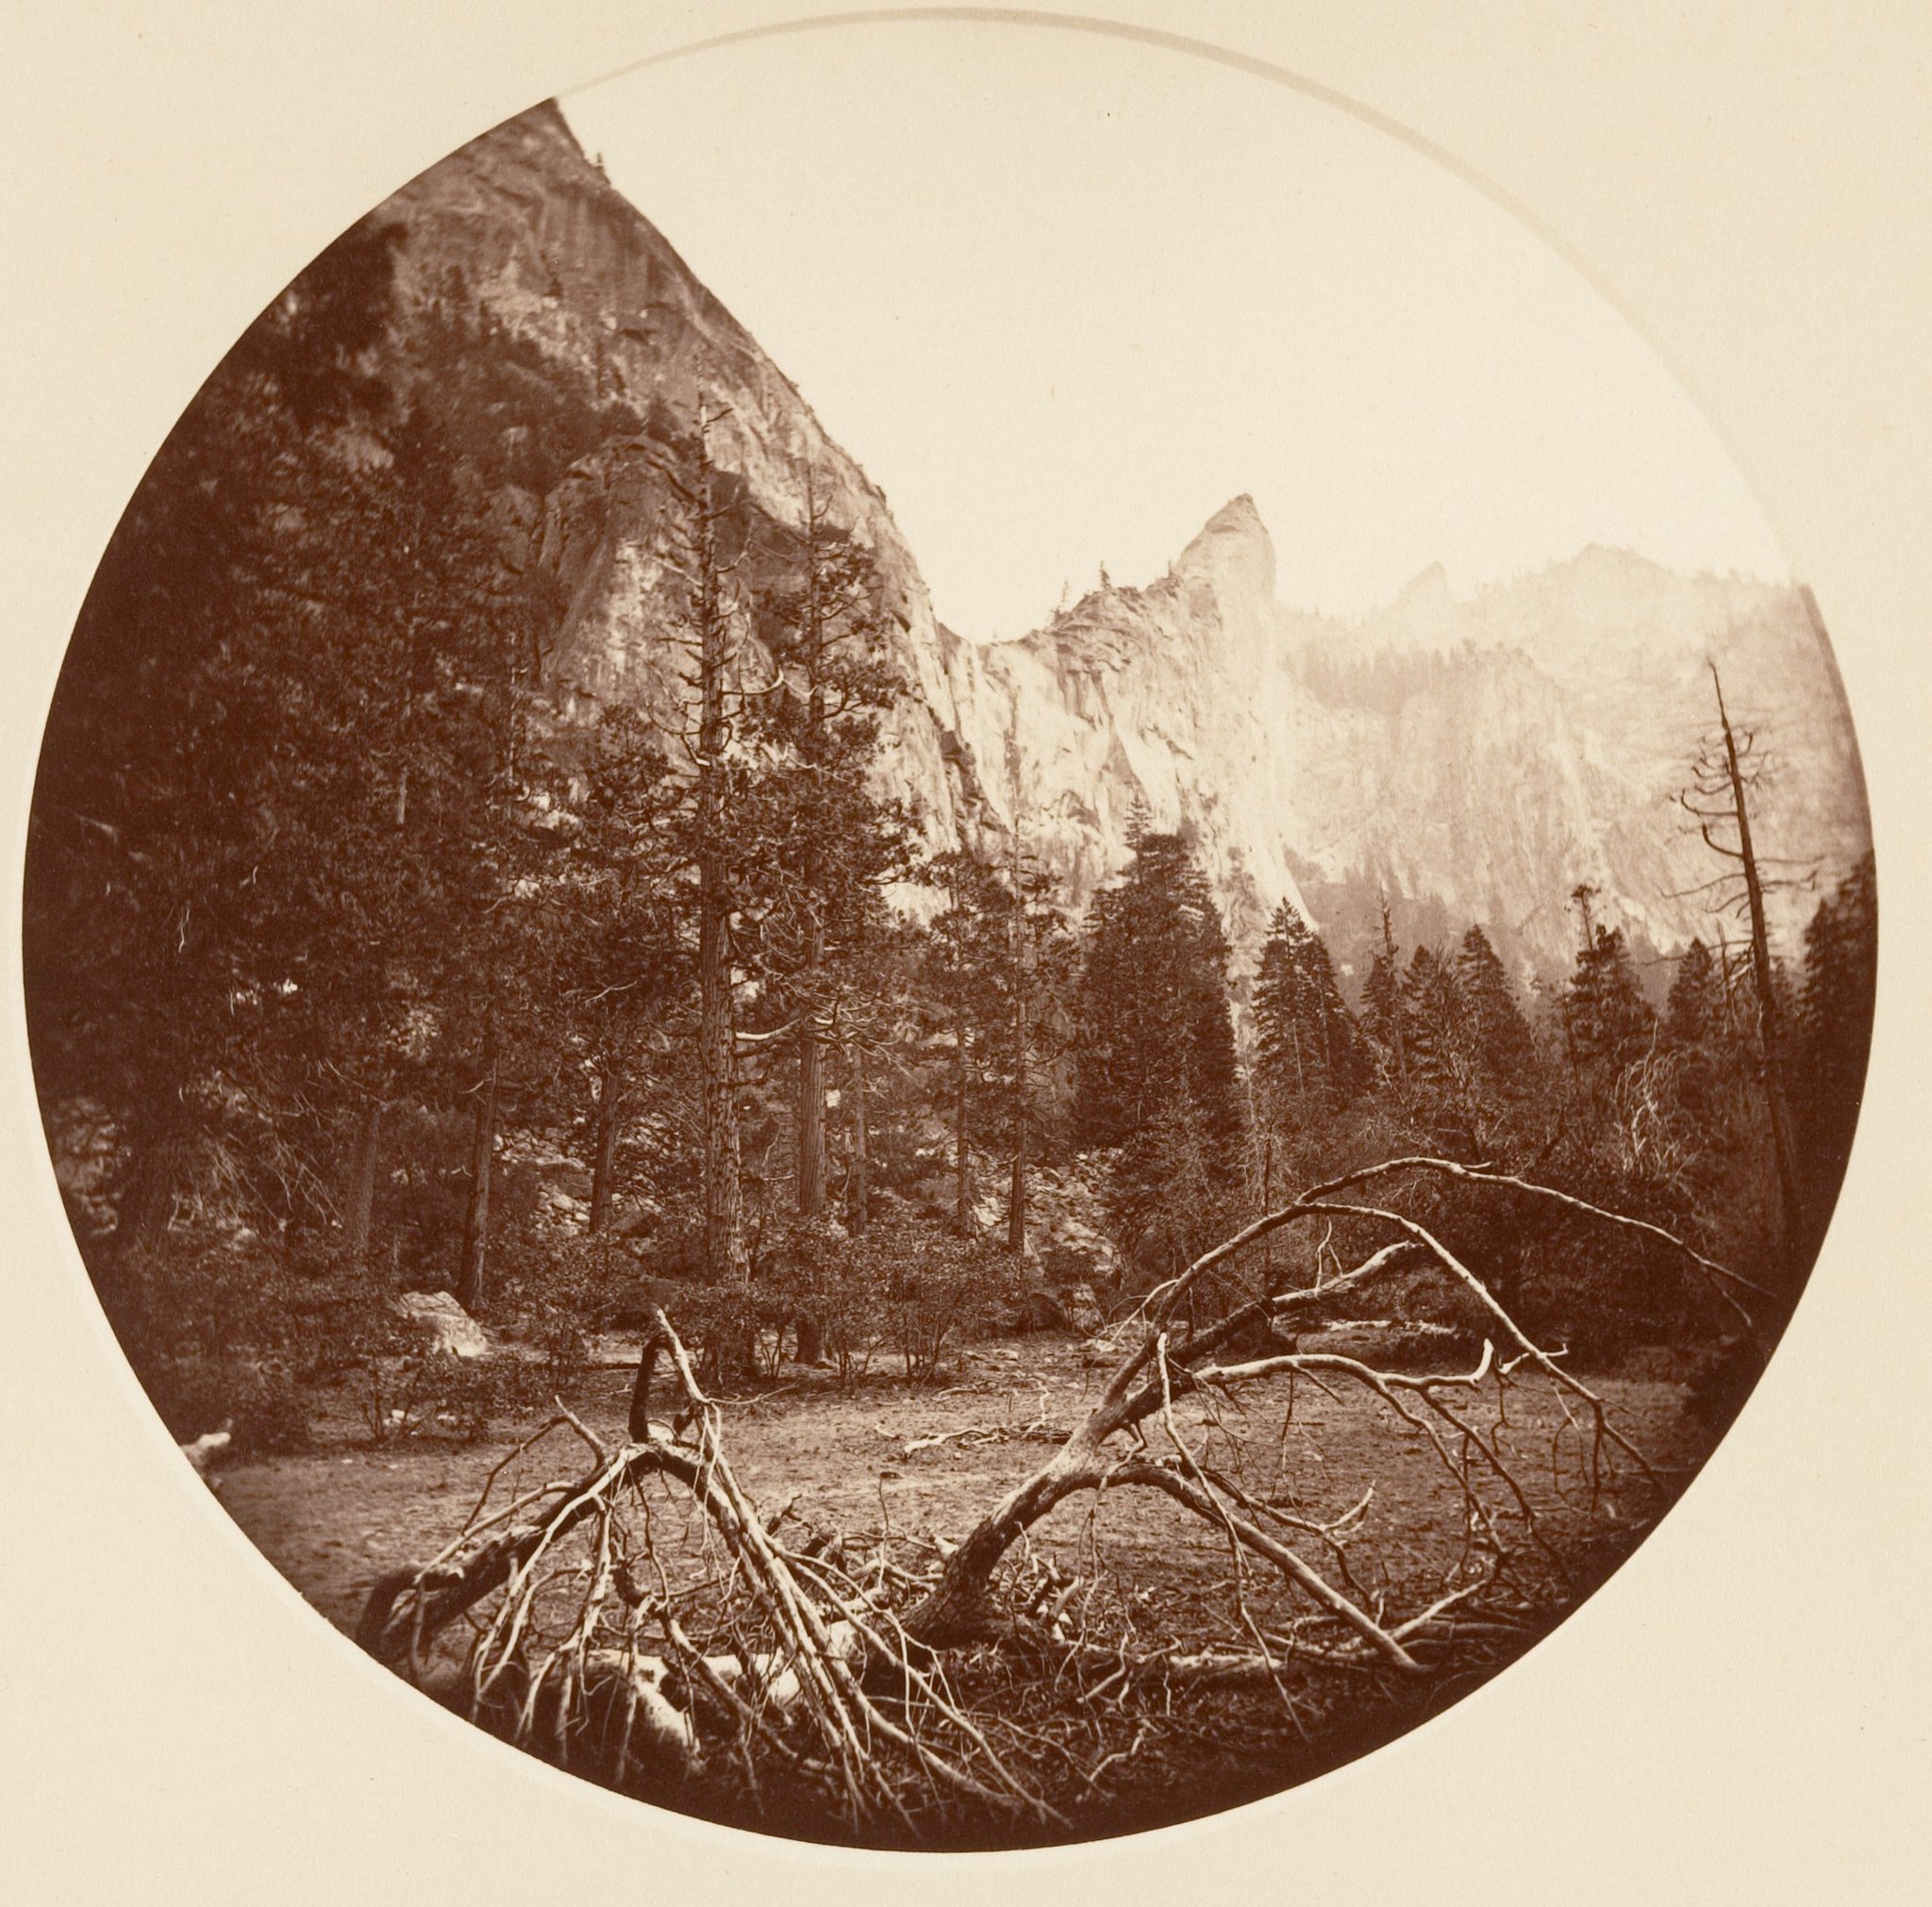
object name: photograph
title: [Yosemite National Park, California]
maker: carleton e. watkins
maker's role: artist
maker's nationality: american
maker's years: 1829-1916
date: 1878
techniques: albumen silver print, glass negative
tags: forests,mountains,landscapes